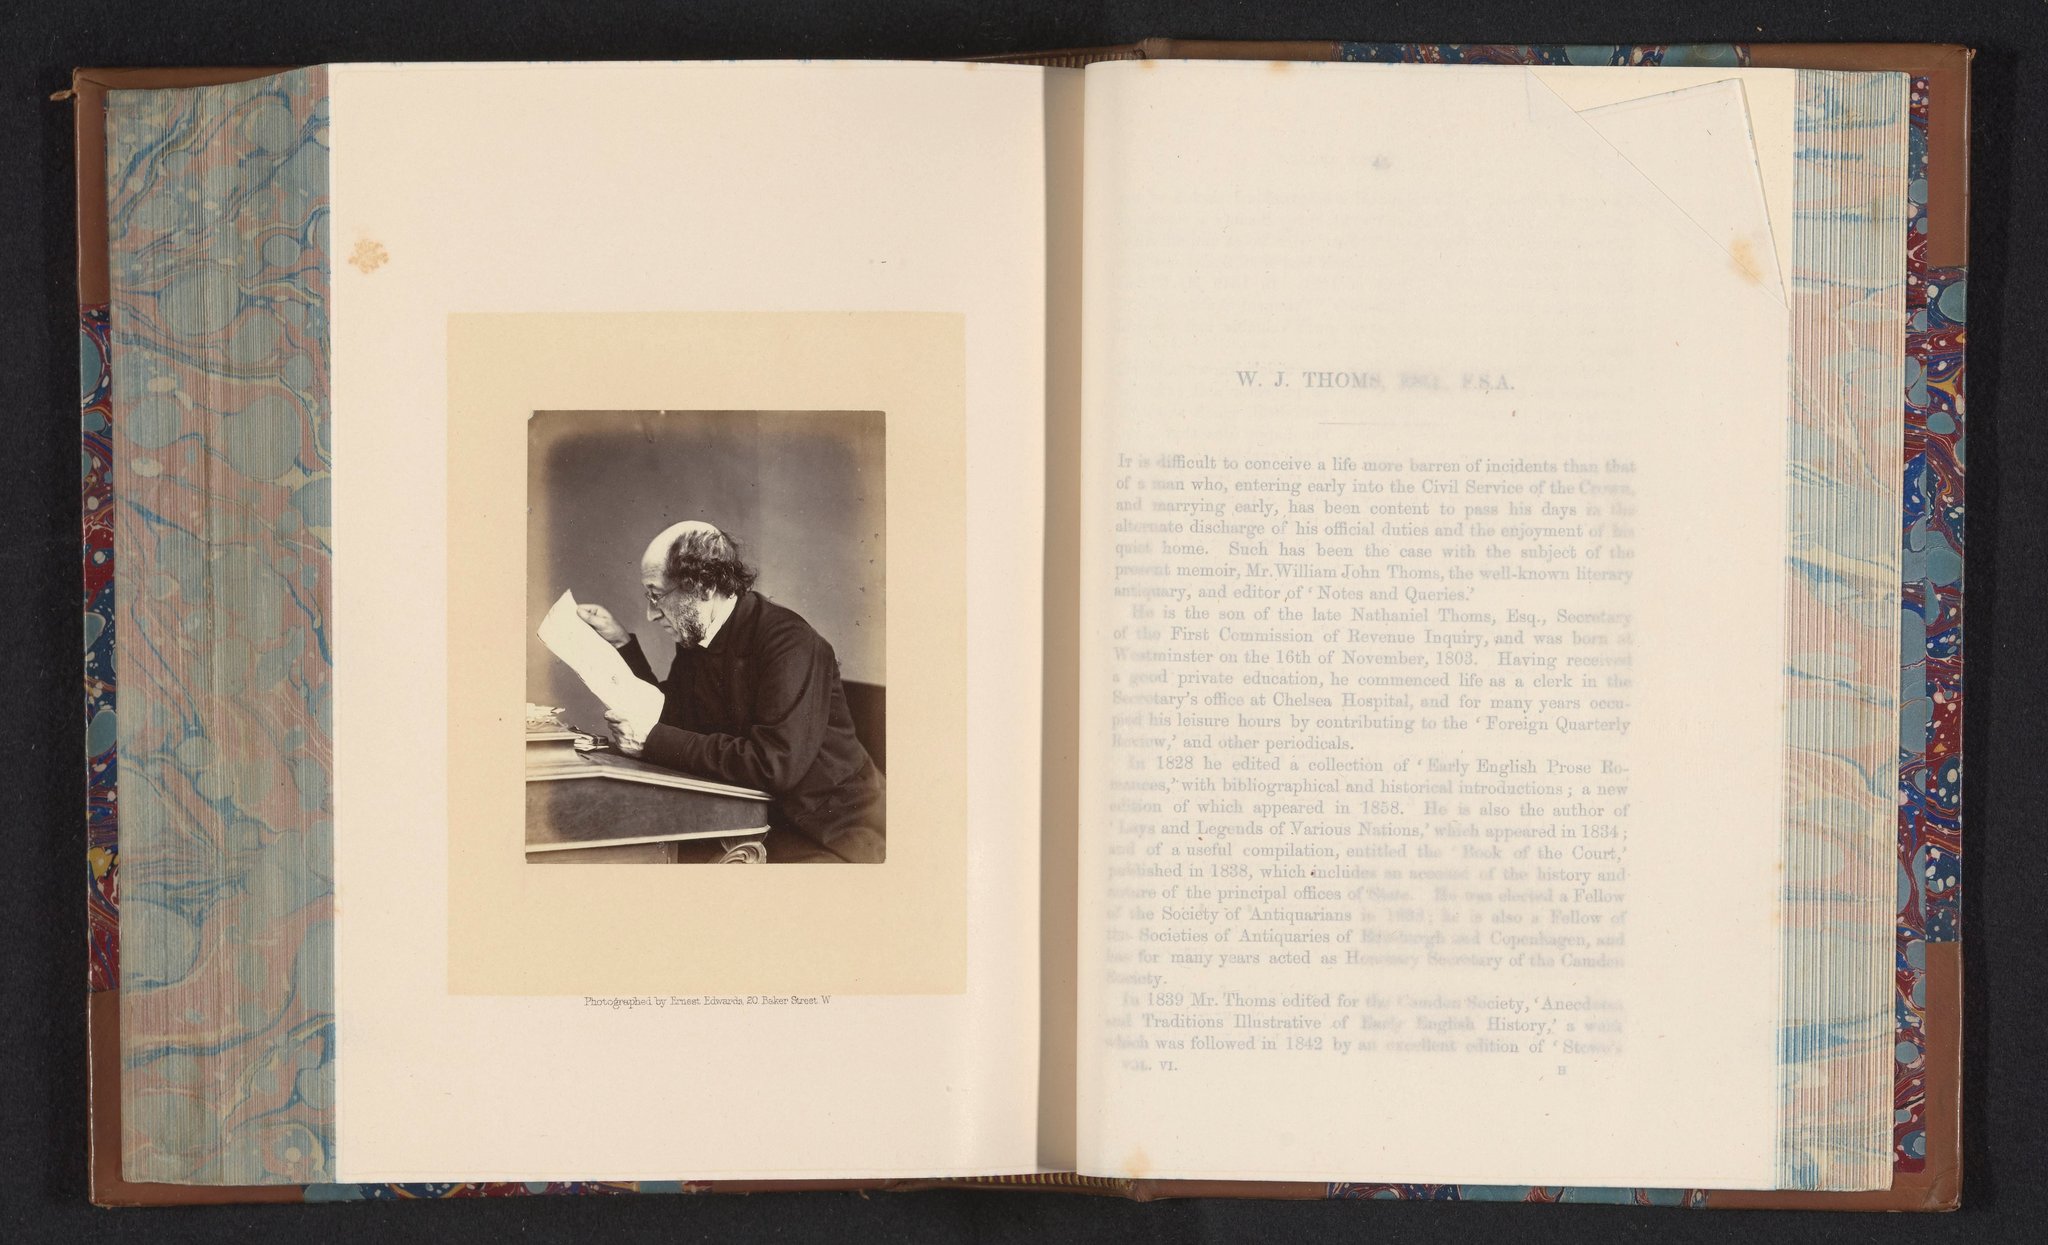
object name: page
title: Portret van William Thoms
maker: ernest edwards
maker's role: fotograaf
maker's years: 1837-1903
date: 1853-1867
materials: photographic support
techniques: albumen print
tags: portrait of a writer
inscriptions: name: ‘Photographed by Ernest Edwards, 20, Baker Street. W.’